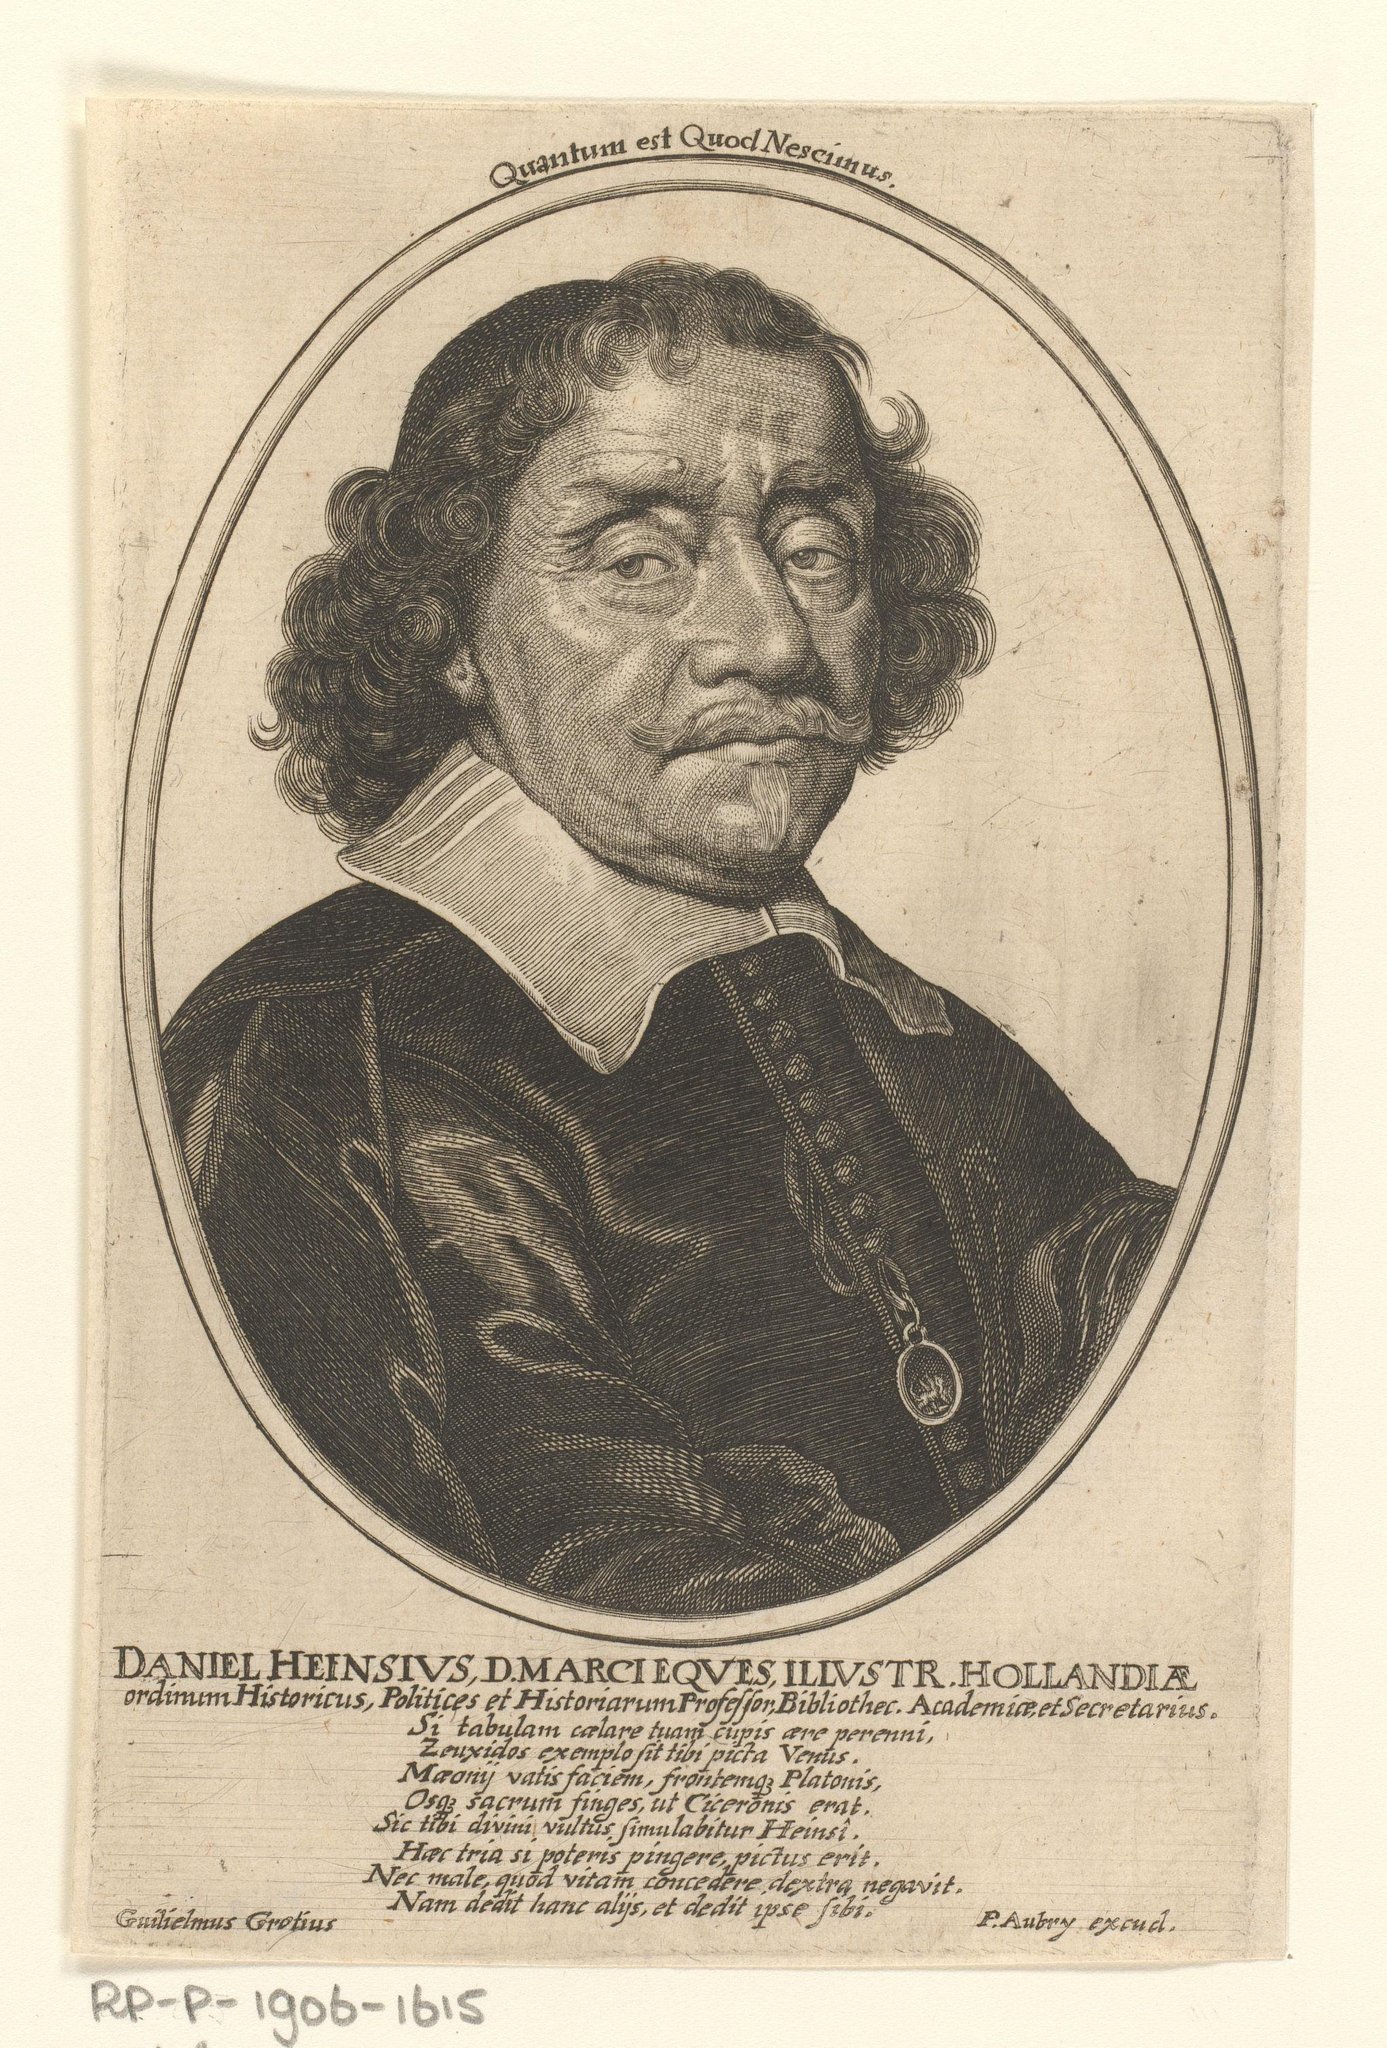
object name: print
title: Portret van Daniël Heinsius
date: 1620-1686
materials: paper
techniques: engraving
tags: ghent, leiden, daniël heinsius, historical persons, portrait of a writer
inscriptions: collector's mark: Lugt 2228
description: Met tienregelig onderschrift in het Latijn.